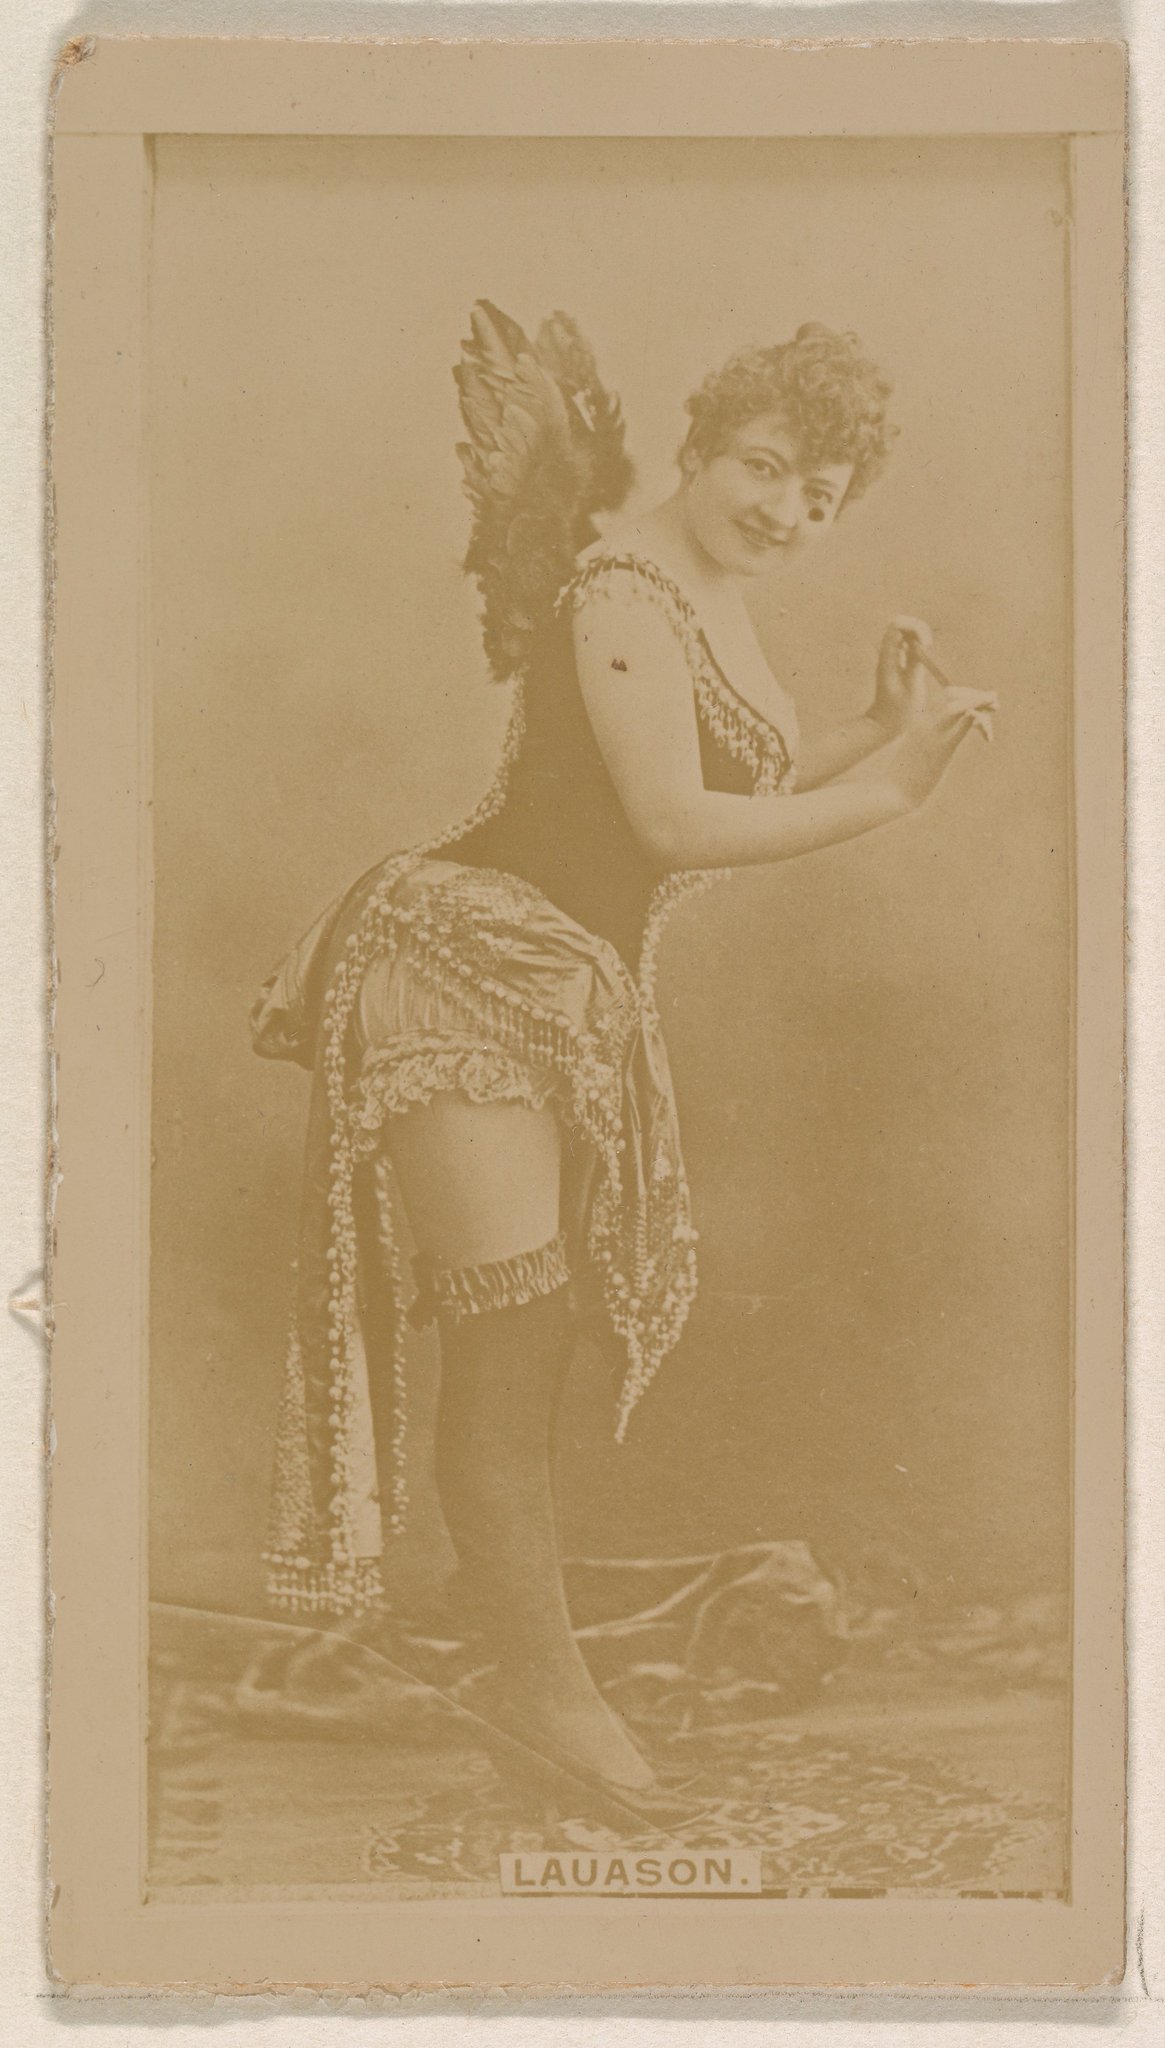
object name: photograph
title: Miss Lauason, from the Actresses series (N245) issued by Kinney Brothers to promote Sweet Caporal Cigarettes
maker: kinney brothers tobacco company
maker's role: publisher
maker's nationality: american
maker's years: 1869-2011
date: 1890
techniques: albumen silver print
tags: portraits,women,actresses